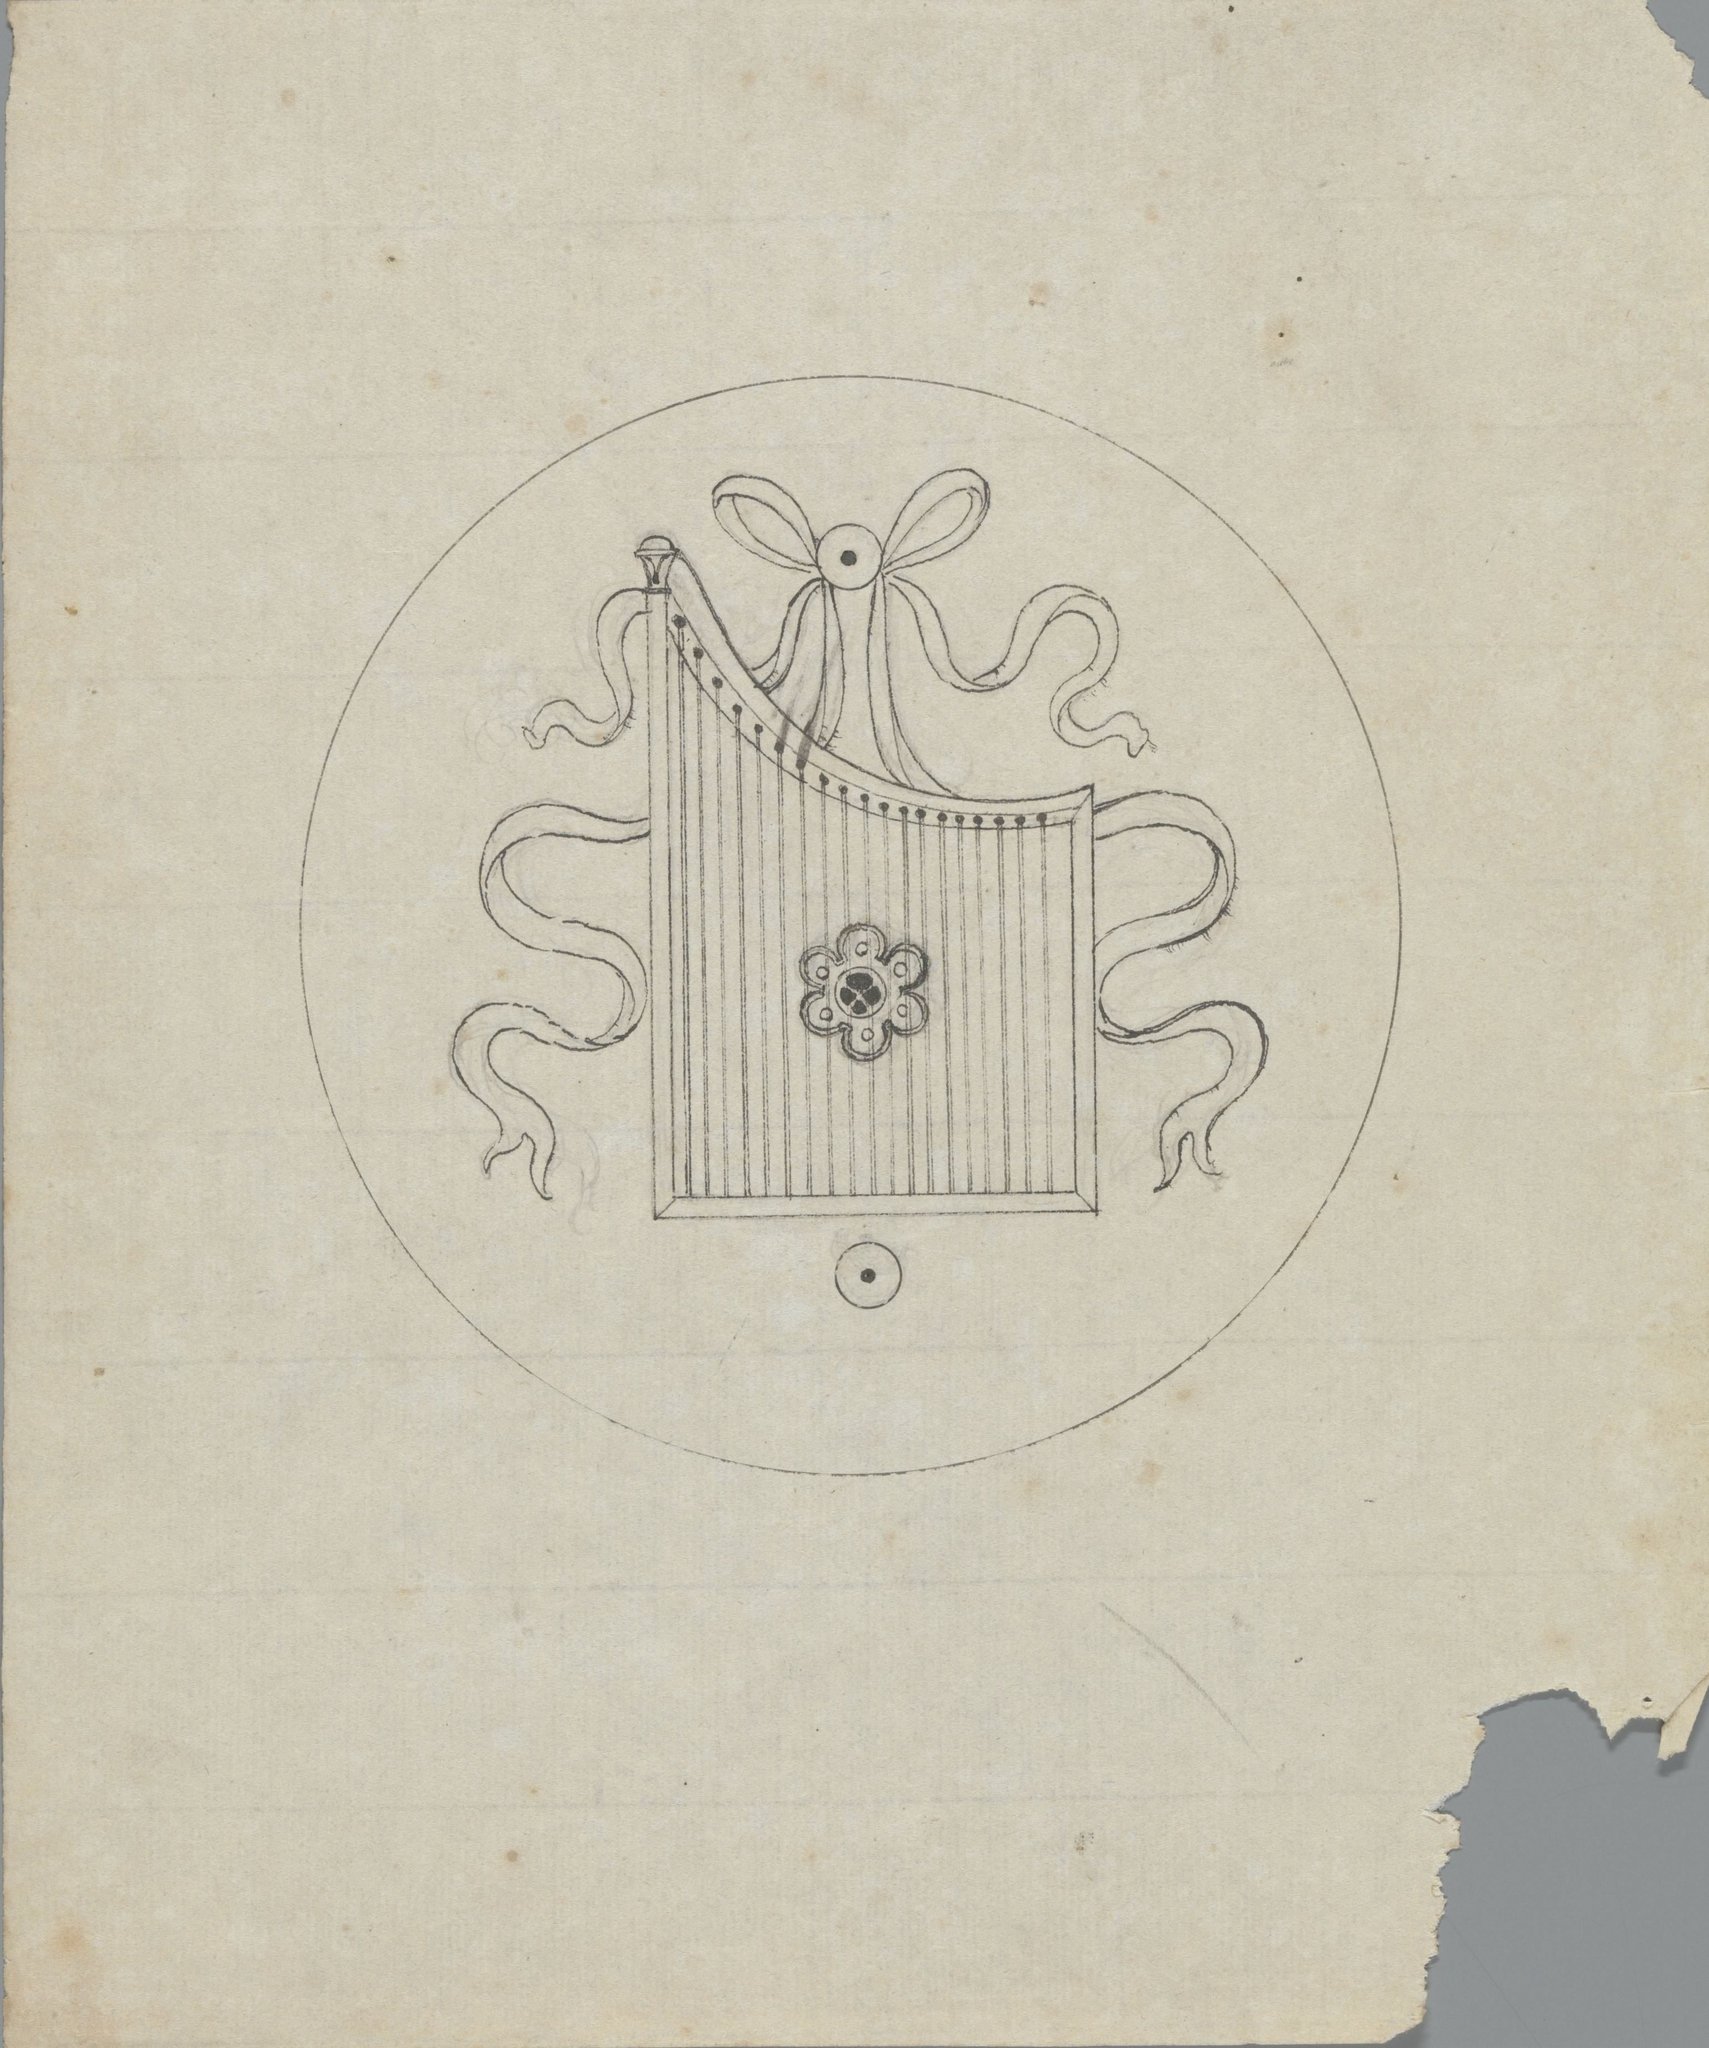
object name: design drawing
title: Snaarinstrument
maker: pierre félix van doren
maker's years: 1797-1856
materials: graphite, ink, paper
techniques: pen in black ink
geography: brussels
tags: trophy, i.e.: decorative arrangement of symbolic or typical objects ~ ornament, string instruments (plucked)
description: Een van 103 ontwerpen voor marqueterie van aan linten opgehangen muziekinstrumenten in ronde medaillons, bestemd voor de set stoelen gemaakt door Van Doren voor de grote zaal van het Paleis van de Prins van Oranje in Brussel in 1828.